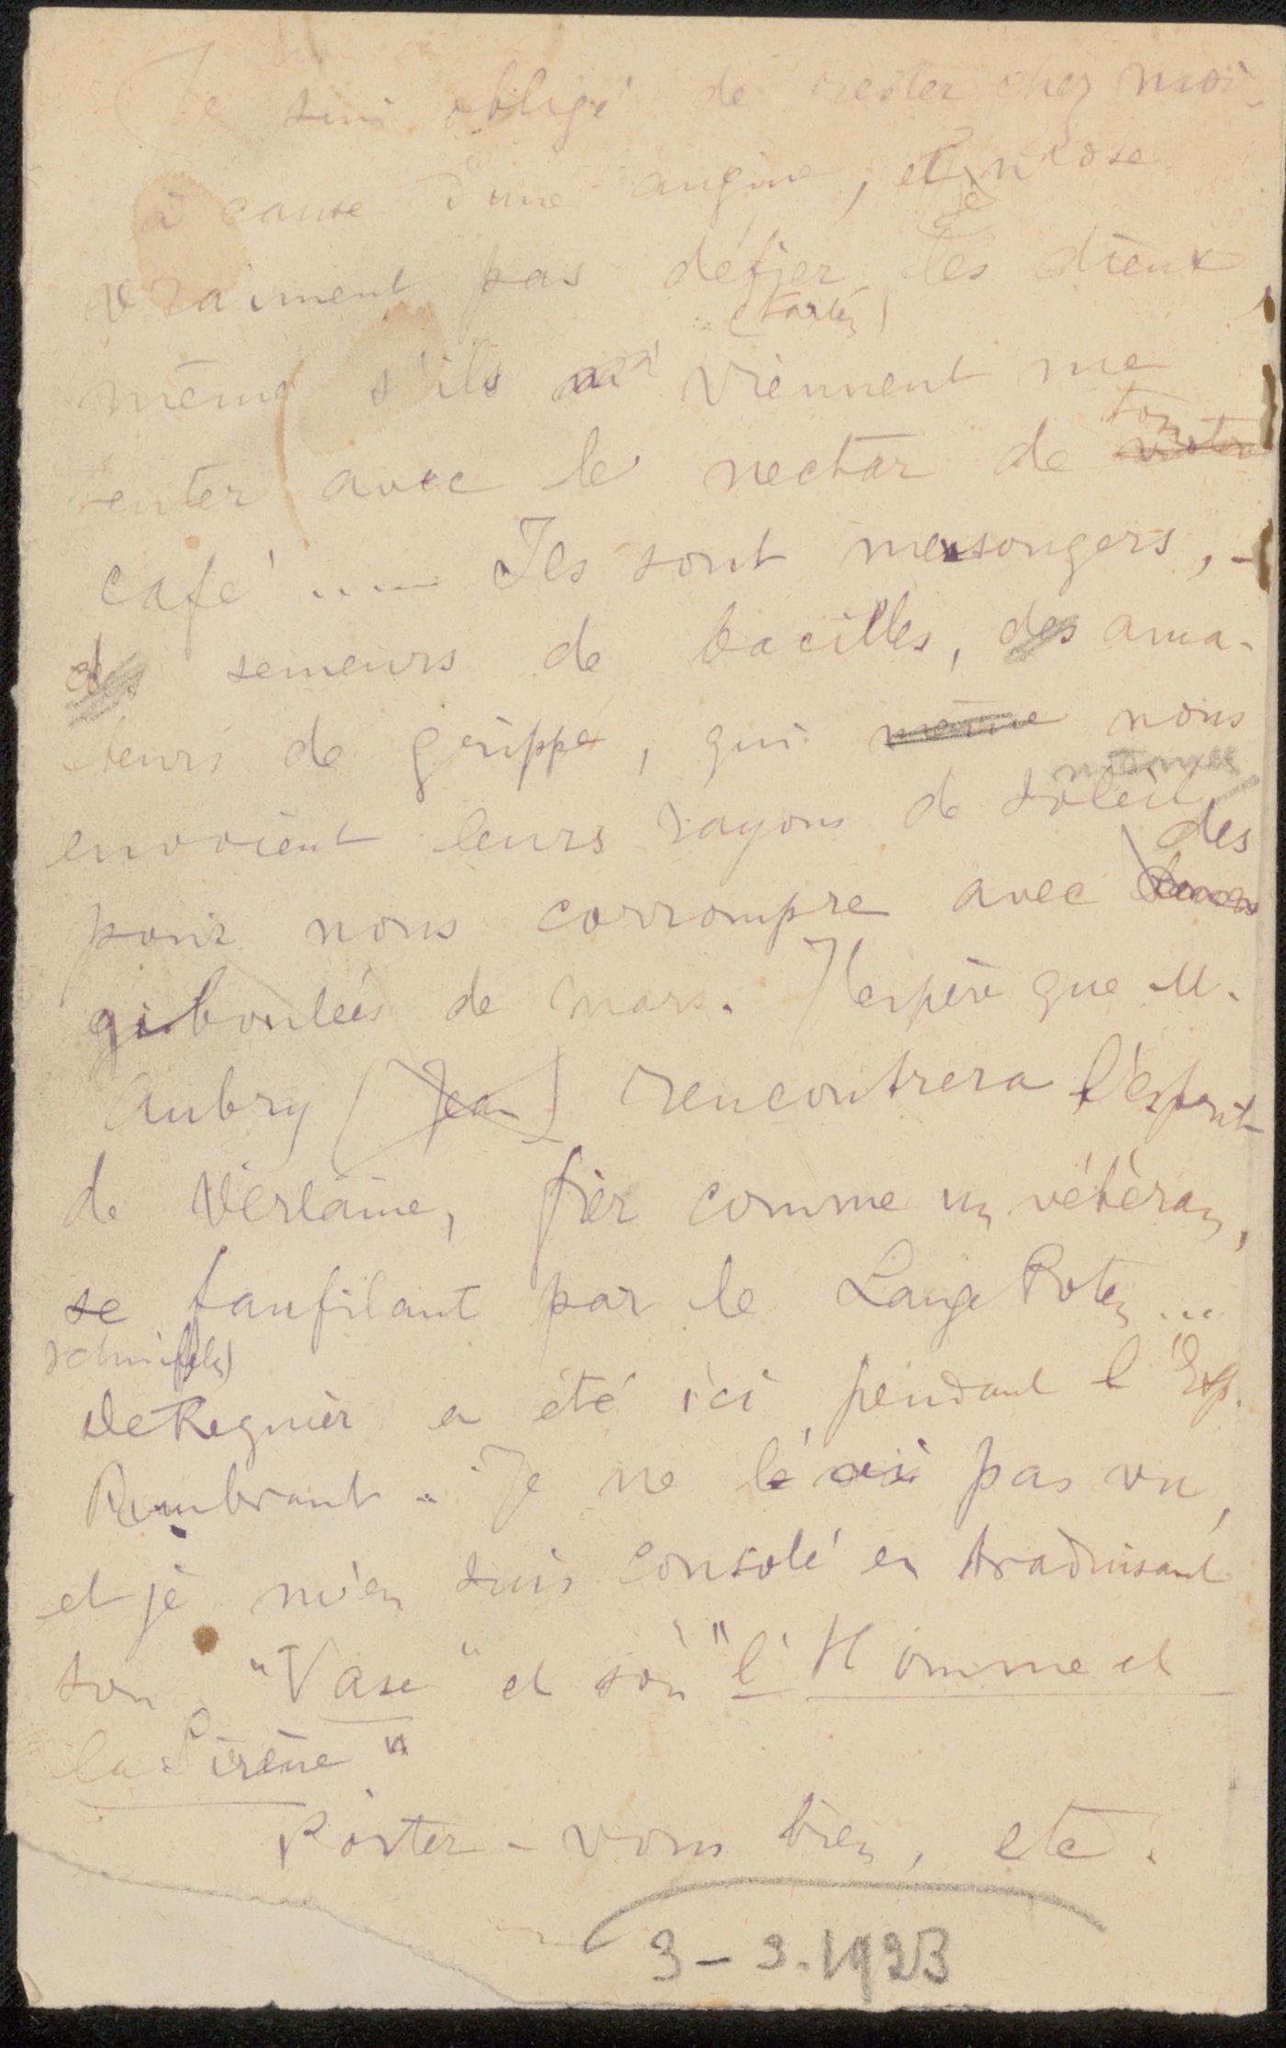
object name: aantekening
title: Aantekening uit archief Philip Zilcken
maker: philip zilcken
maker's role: draughtsman, painter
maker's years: 1857-1930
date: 1867-1930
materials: ink, paper, pencil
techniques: pen, writing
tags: leiden, amsterdam, painter, print maker, draughtsman, rembrandt van rijn, paul verlaine, paris, exhibition ~ art, diseases, the hague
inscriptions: collector's mark: ‘RPK’